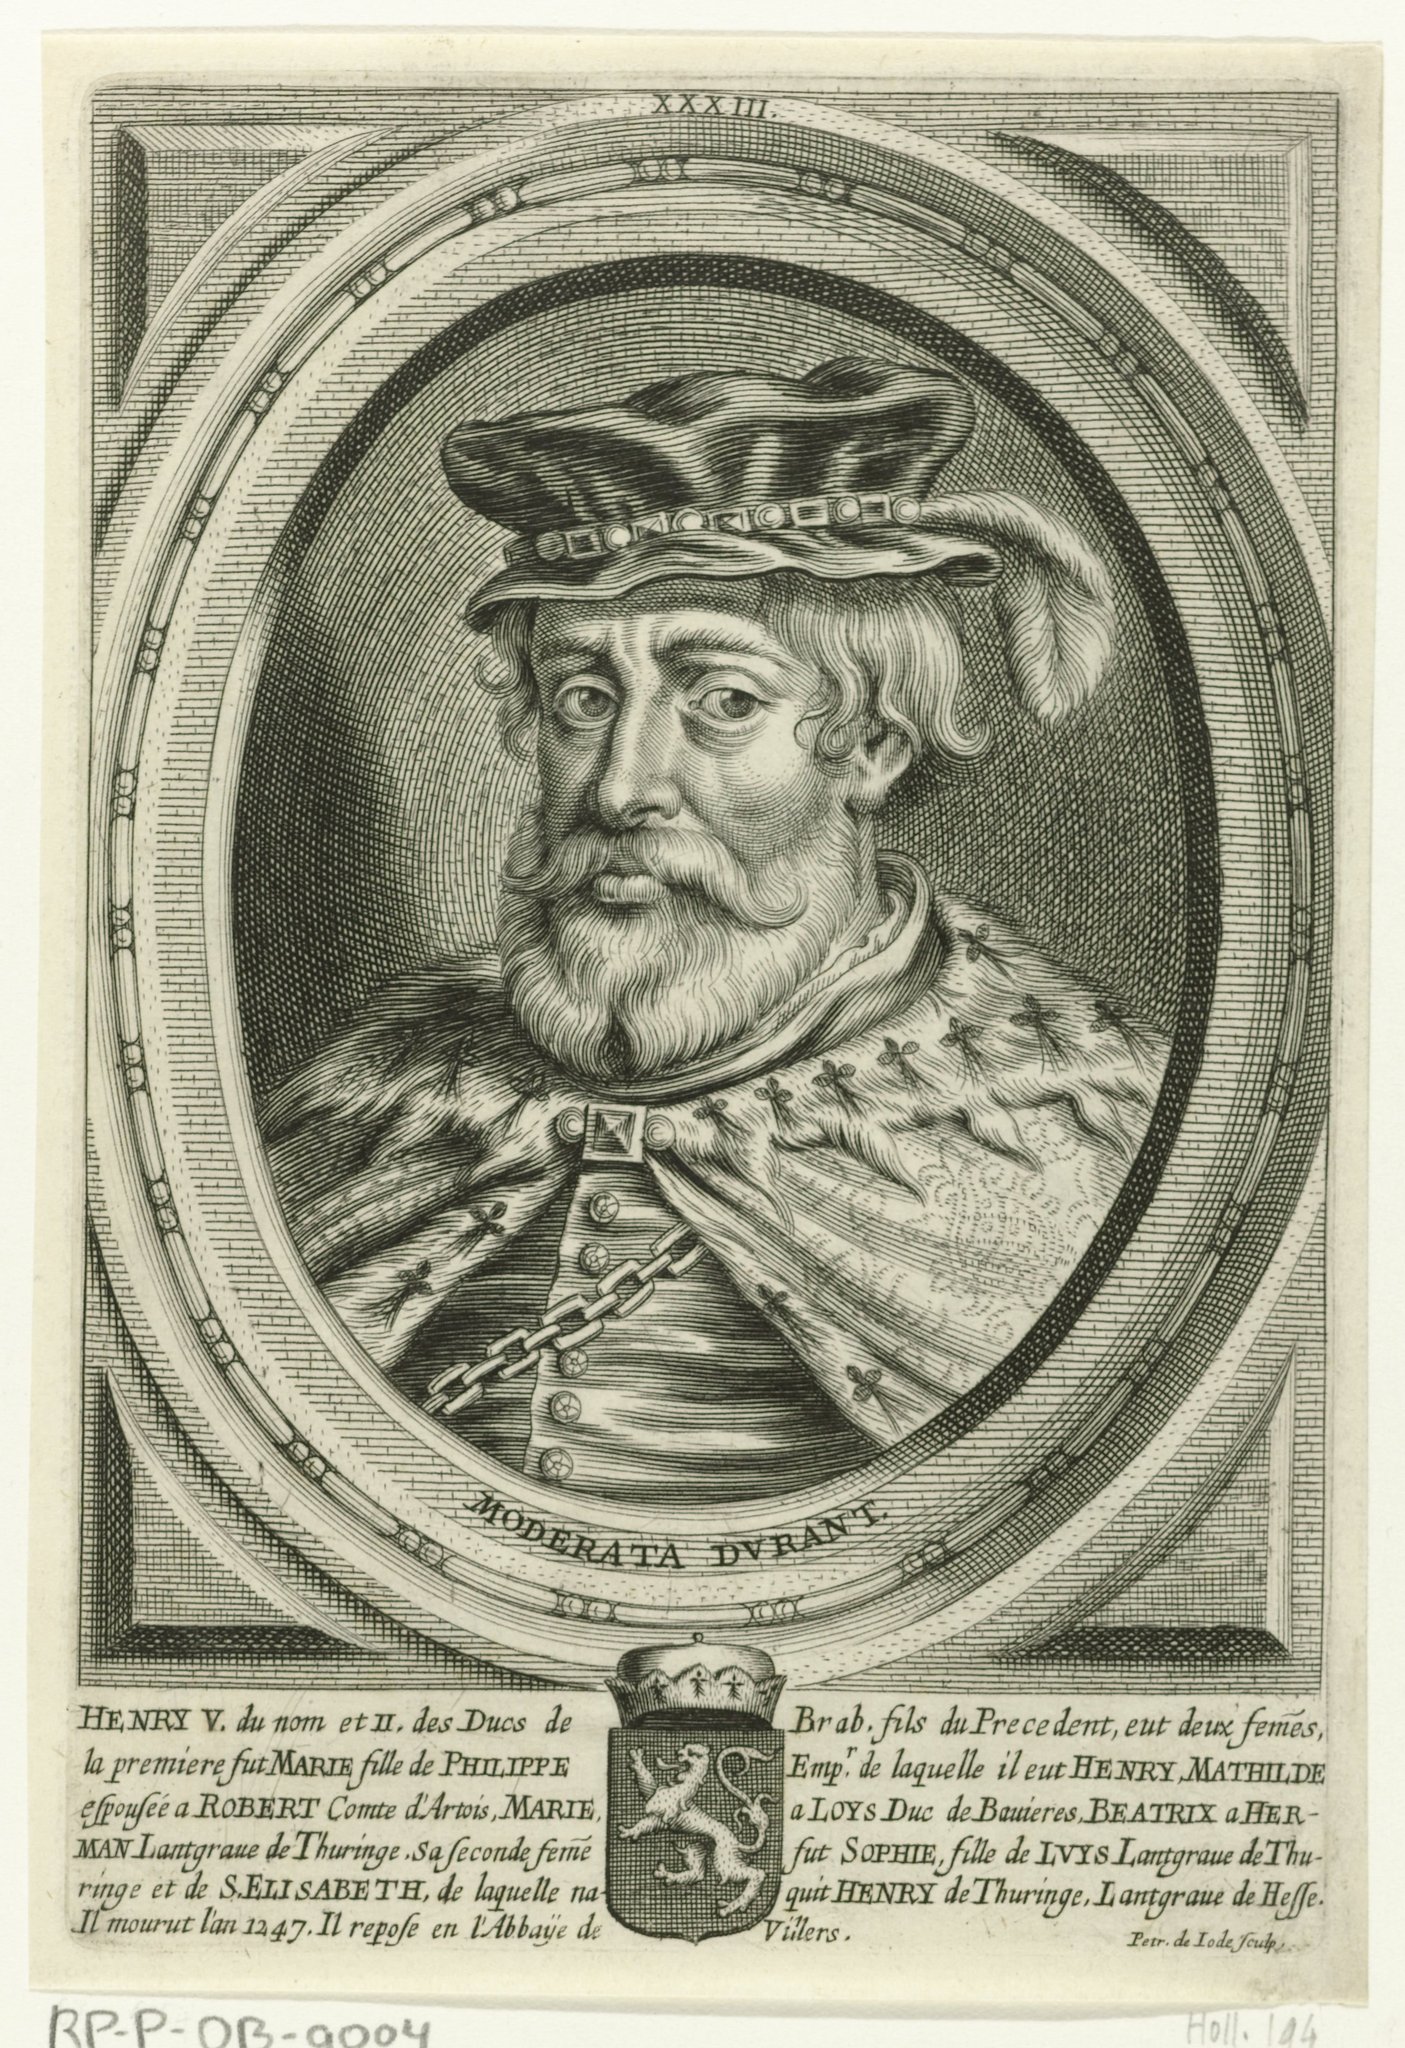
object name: book illustration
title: Portret van Hendrik V, hertog van Brabant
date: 1661-1663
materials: paper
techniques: engraving, etching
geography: antwerp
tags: hendrik v (hertog van brabant)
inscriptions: collector's mark: Lugt 2228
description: Busteportret van Hendrik V, met gevederde hoed. Het portret is gevat in een ovale omlijsting met vierkant randwerk en een motto in het Latijn. In de marge het wapenschild van de geportretteerde en een zesregelig onderschrift in het Frans. Prent uit een boek waarin 54 prenten met portretten.